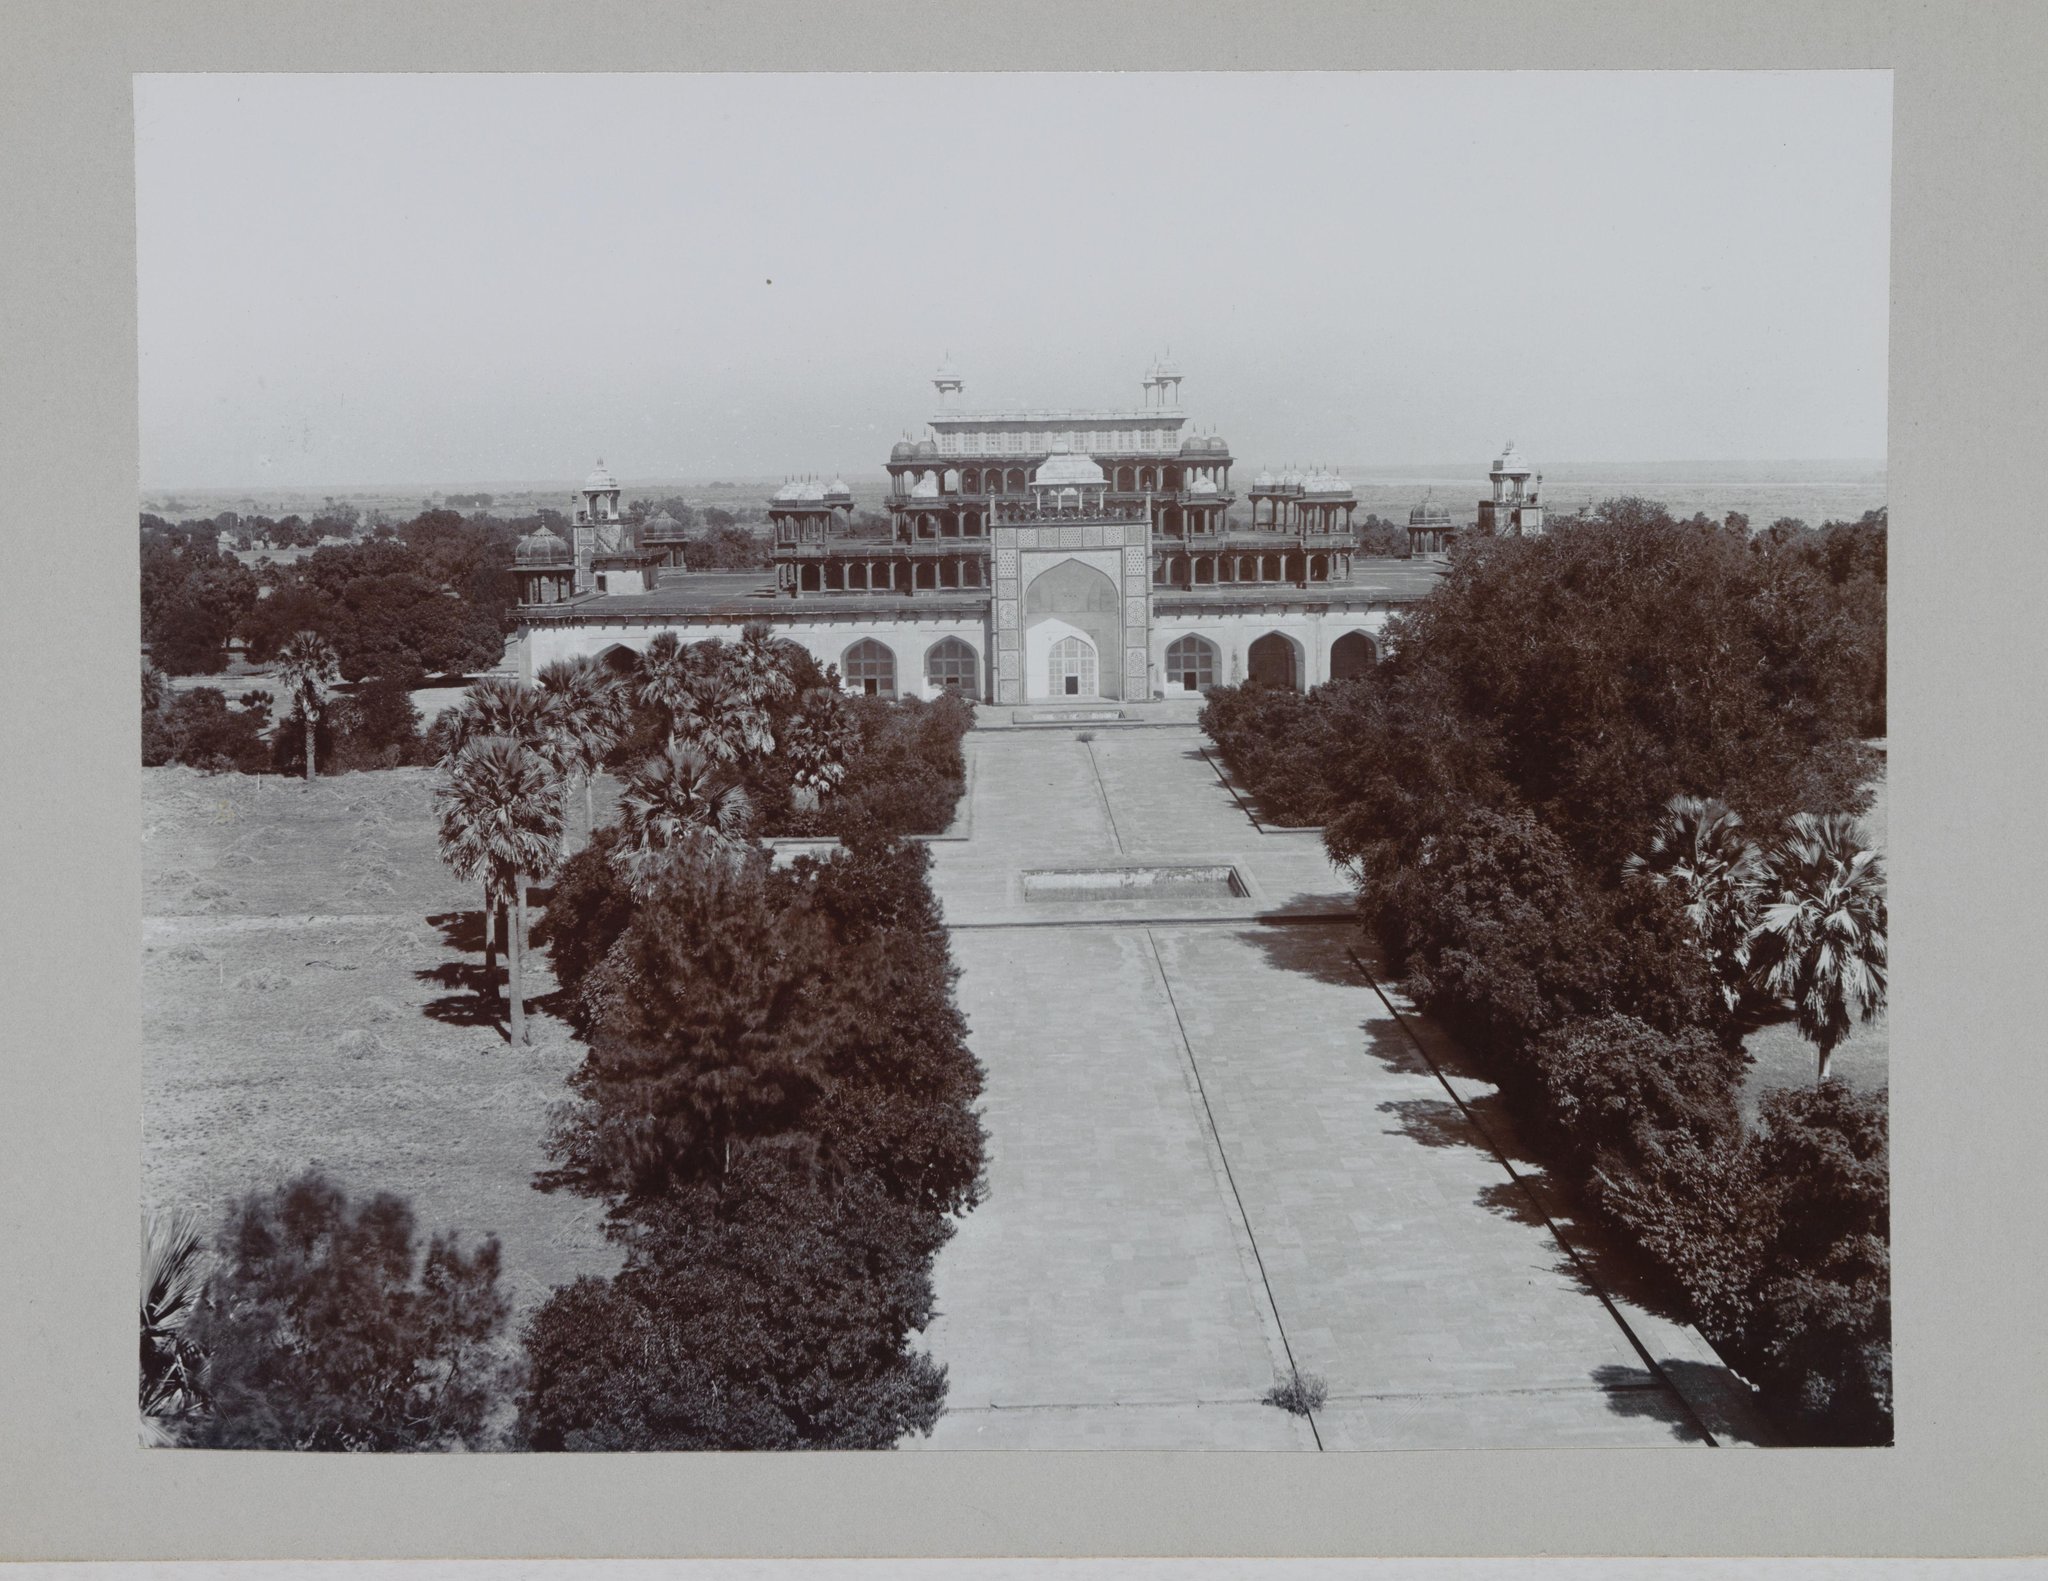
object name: photograph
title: Exterior of Akbar's Tomb in Sikandra, Uttar Pradesh, India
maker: Anonymous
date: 1895-1915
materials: cardboard, paper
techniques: gelatin silver print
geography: sikandra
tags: sikandra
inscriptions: annotation: ‘49. Mausoleum van Akbar. bij Agra.’